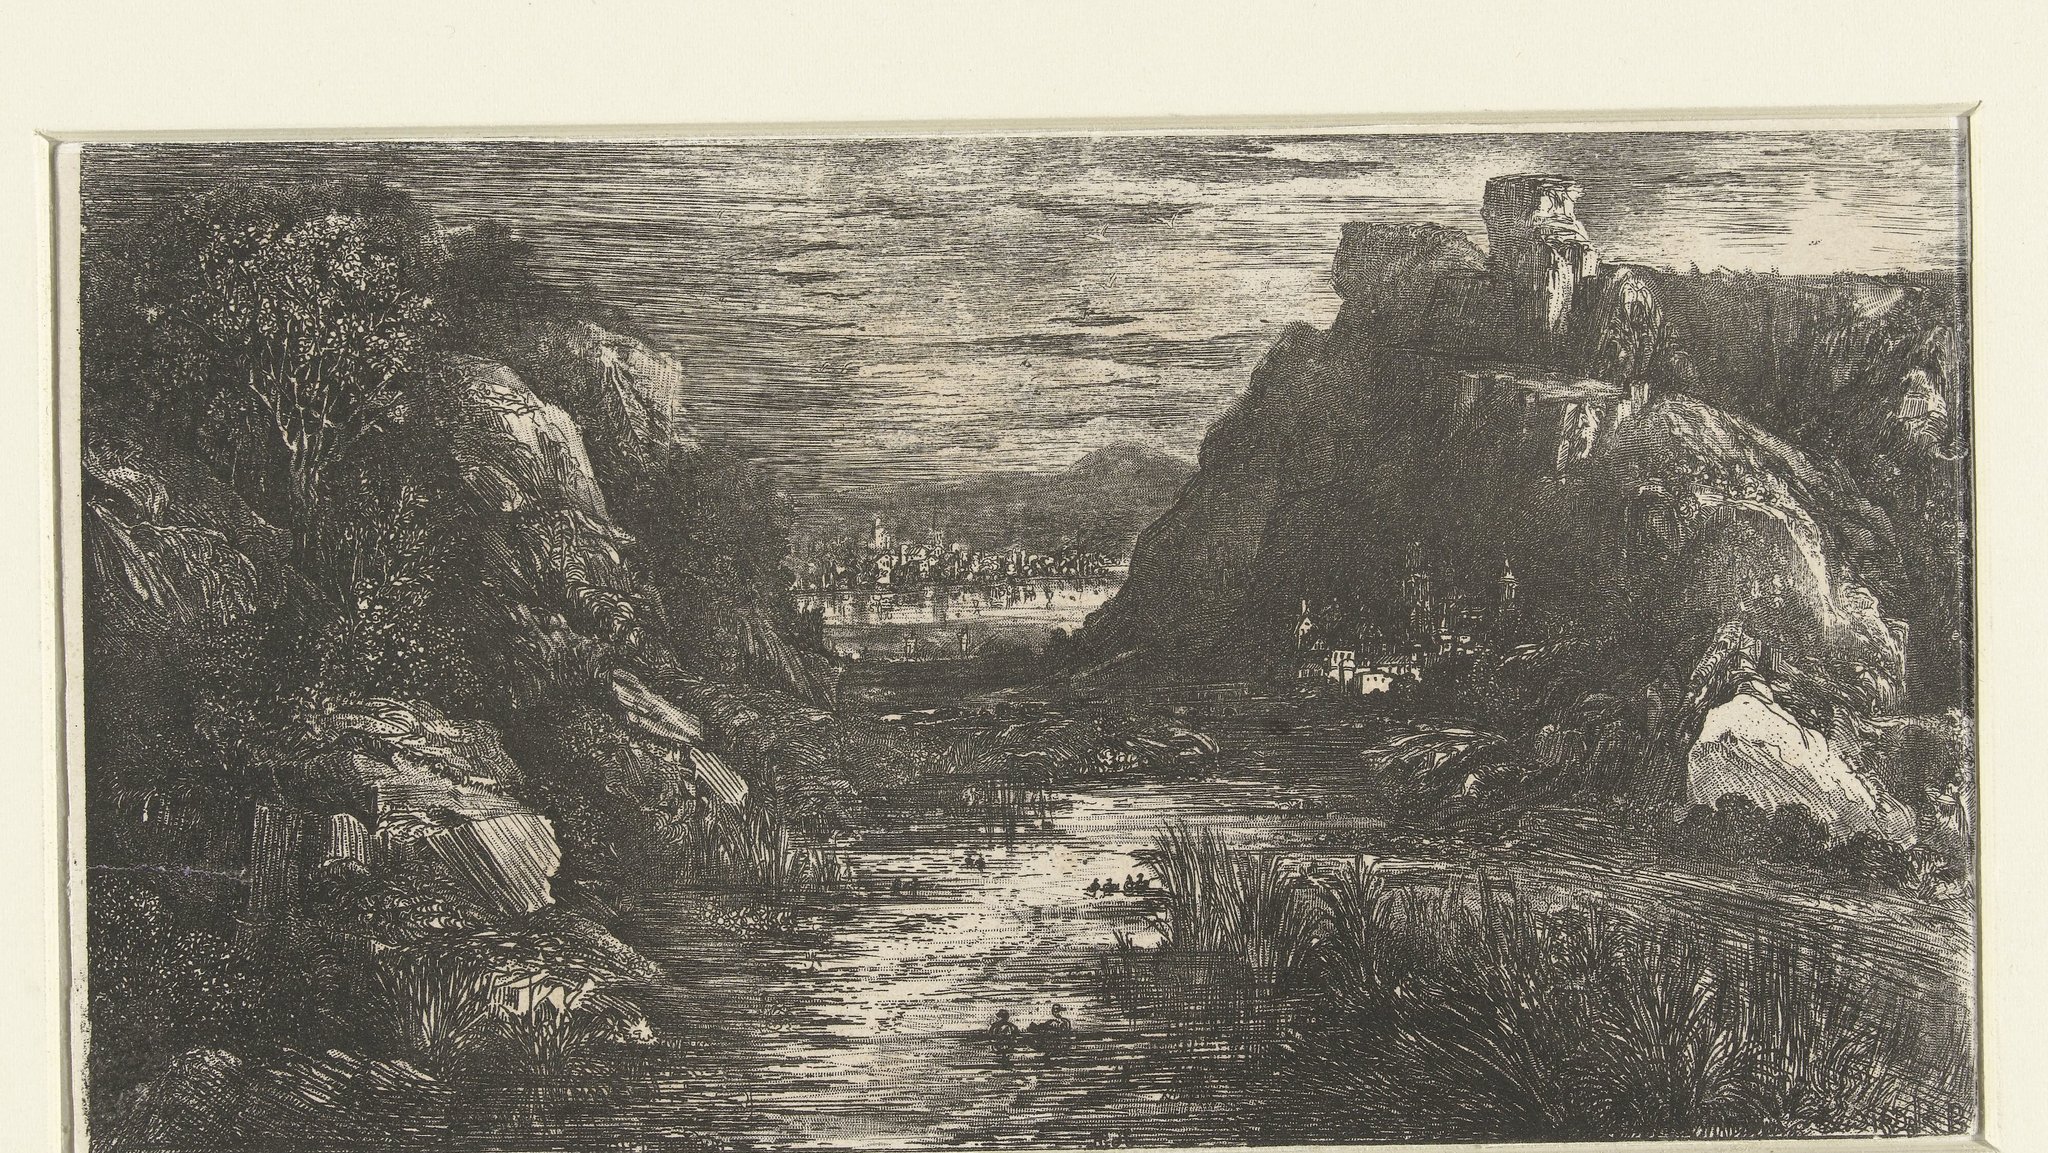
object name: print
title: Landschap met vergezicht op stad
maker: rodolphe bresdin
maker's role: draughtsman, print maker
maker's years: 1822-1885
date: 1868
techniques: printmaking, lithograph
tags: river, rocks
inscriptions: collector's mark: Lugt 2228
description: Landschap met rotsen en rivier met rechts een stad aan de voet van een rots. Een vergezicht toont aan de horizon nog een stad. Het perspectief in de voorstelling is niet helemaal juist. Op de voorgrond zwemmen eenden en staan waterplanten die in verhouding tot de stad op het middenplan veel te groot zijn weergegeven.